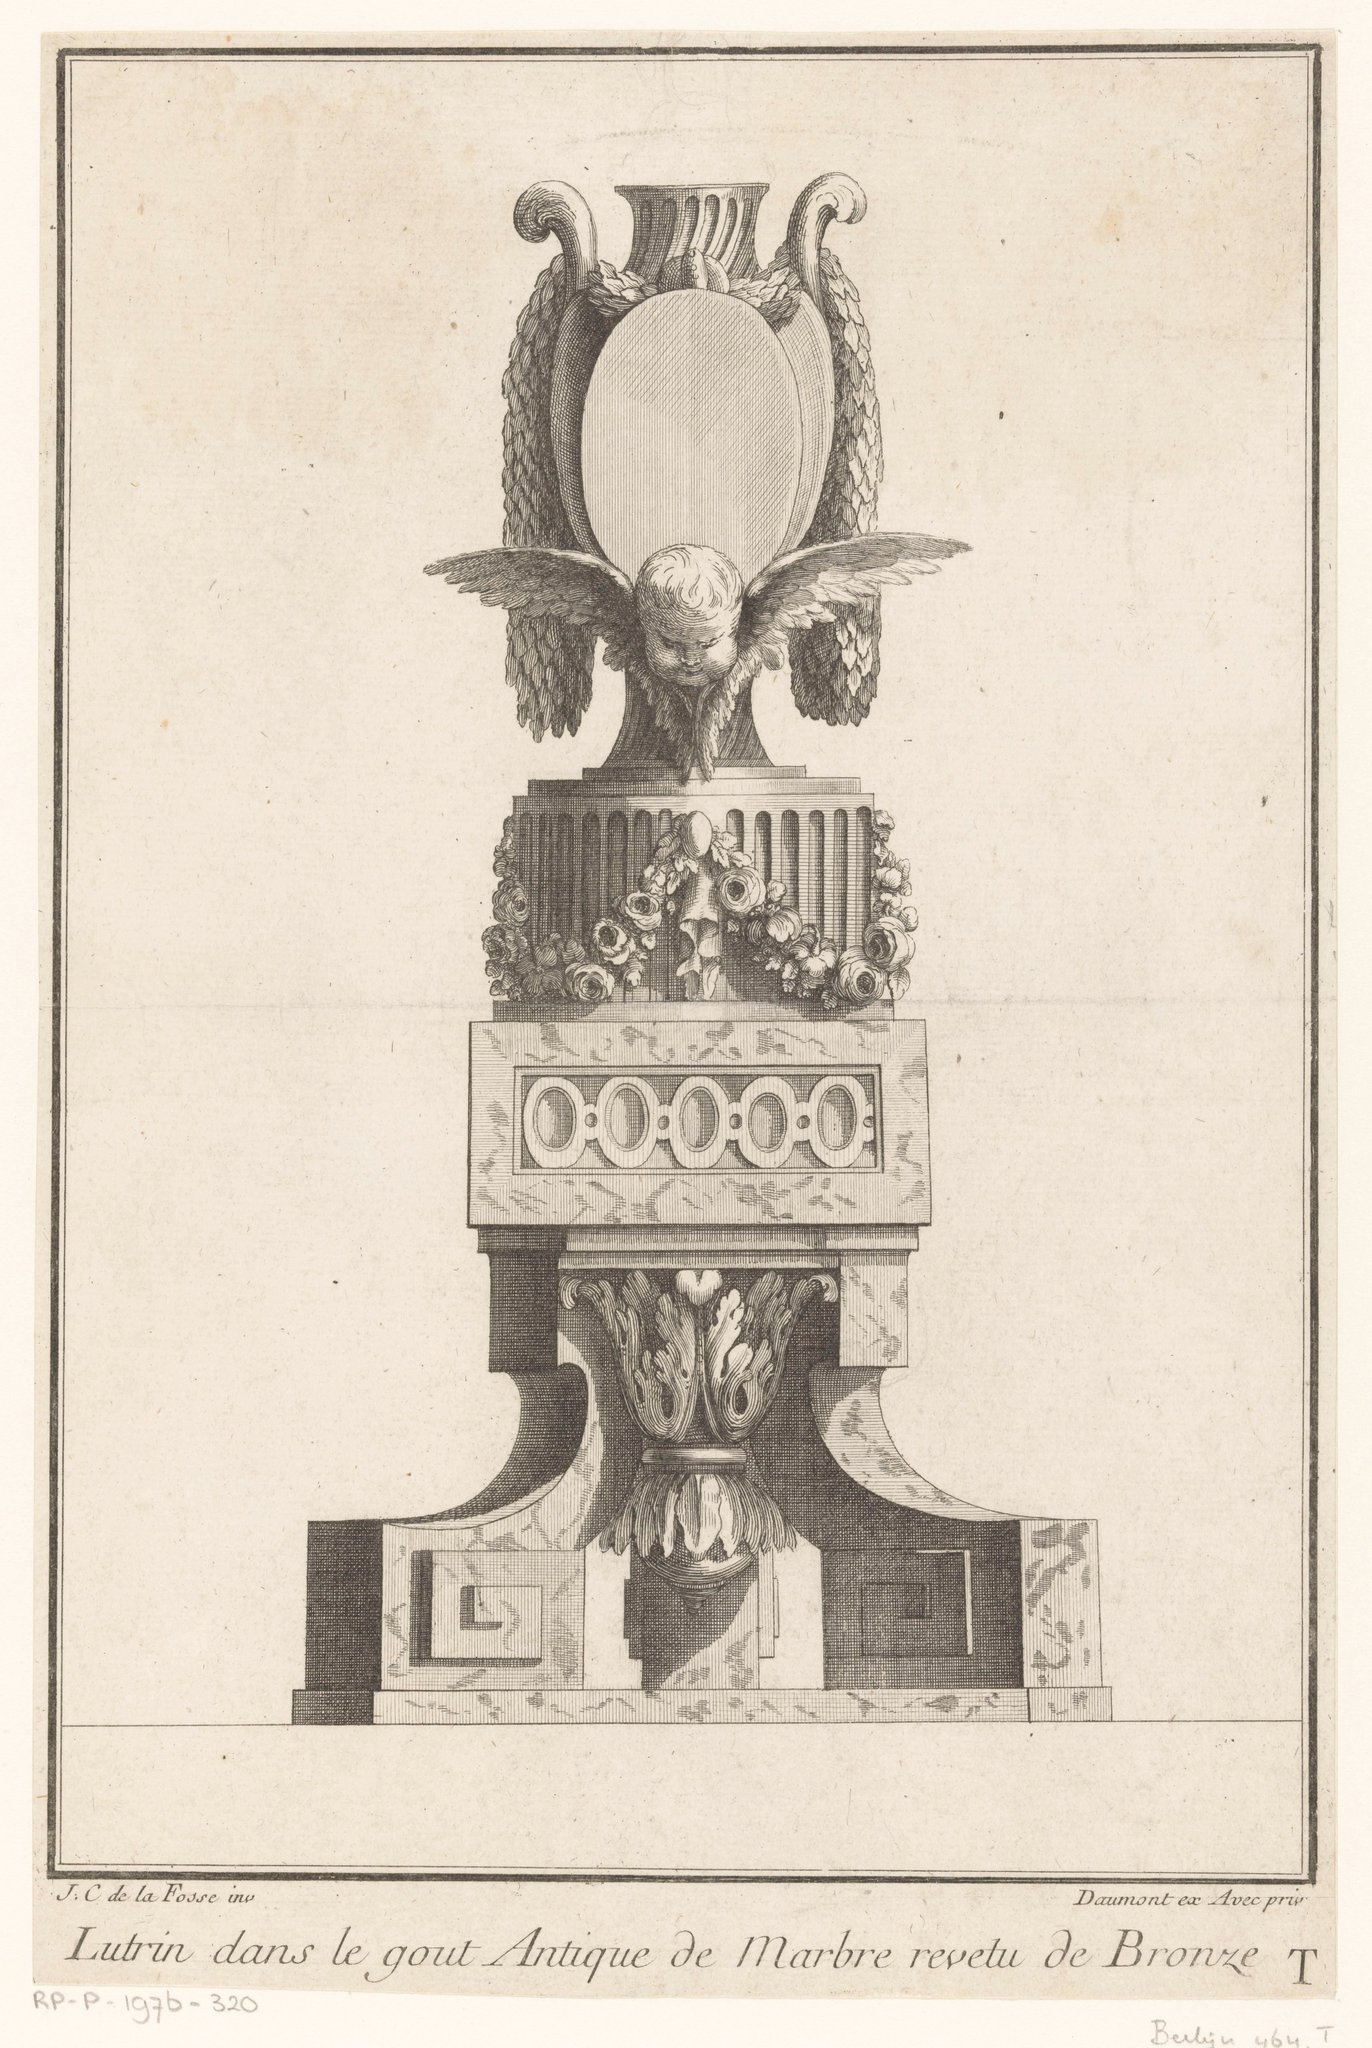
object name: ornament print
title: T Lutrins dans le gout Antique de Marbre revetu de Bronze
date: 1745-1755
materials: paper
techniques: engraving, etching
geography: paris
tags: lectern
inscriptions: collector's mark: Lugt 2228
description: Een lessenaar met guirlandes, een gevleugeld puttohoofd en een vaas met ovaal medaillon.